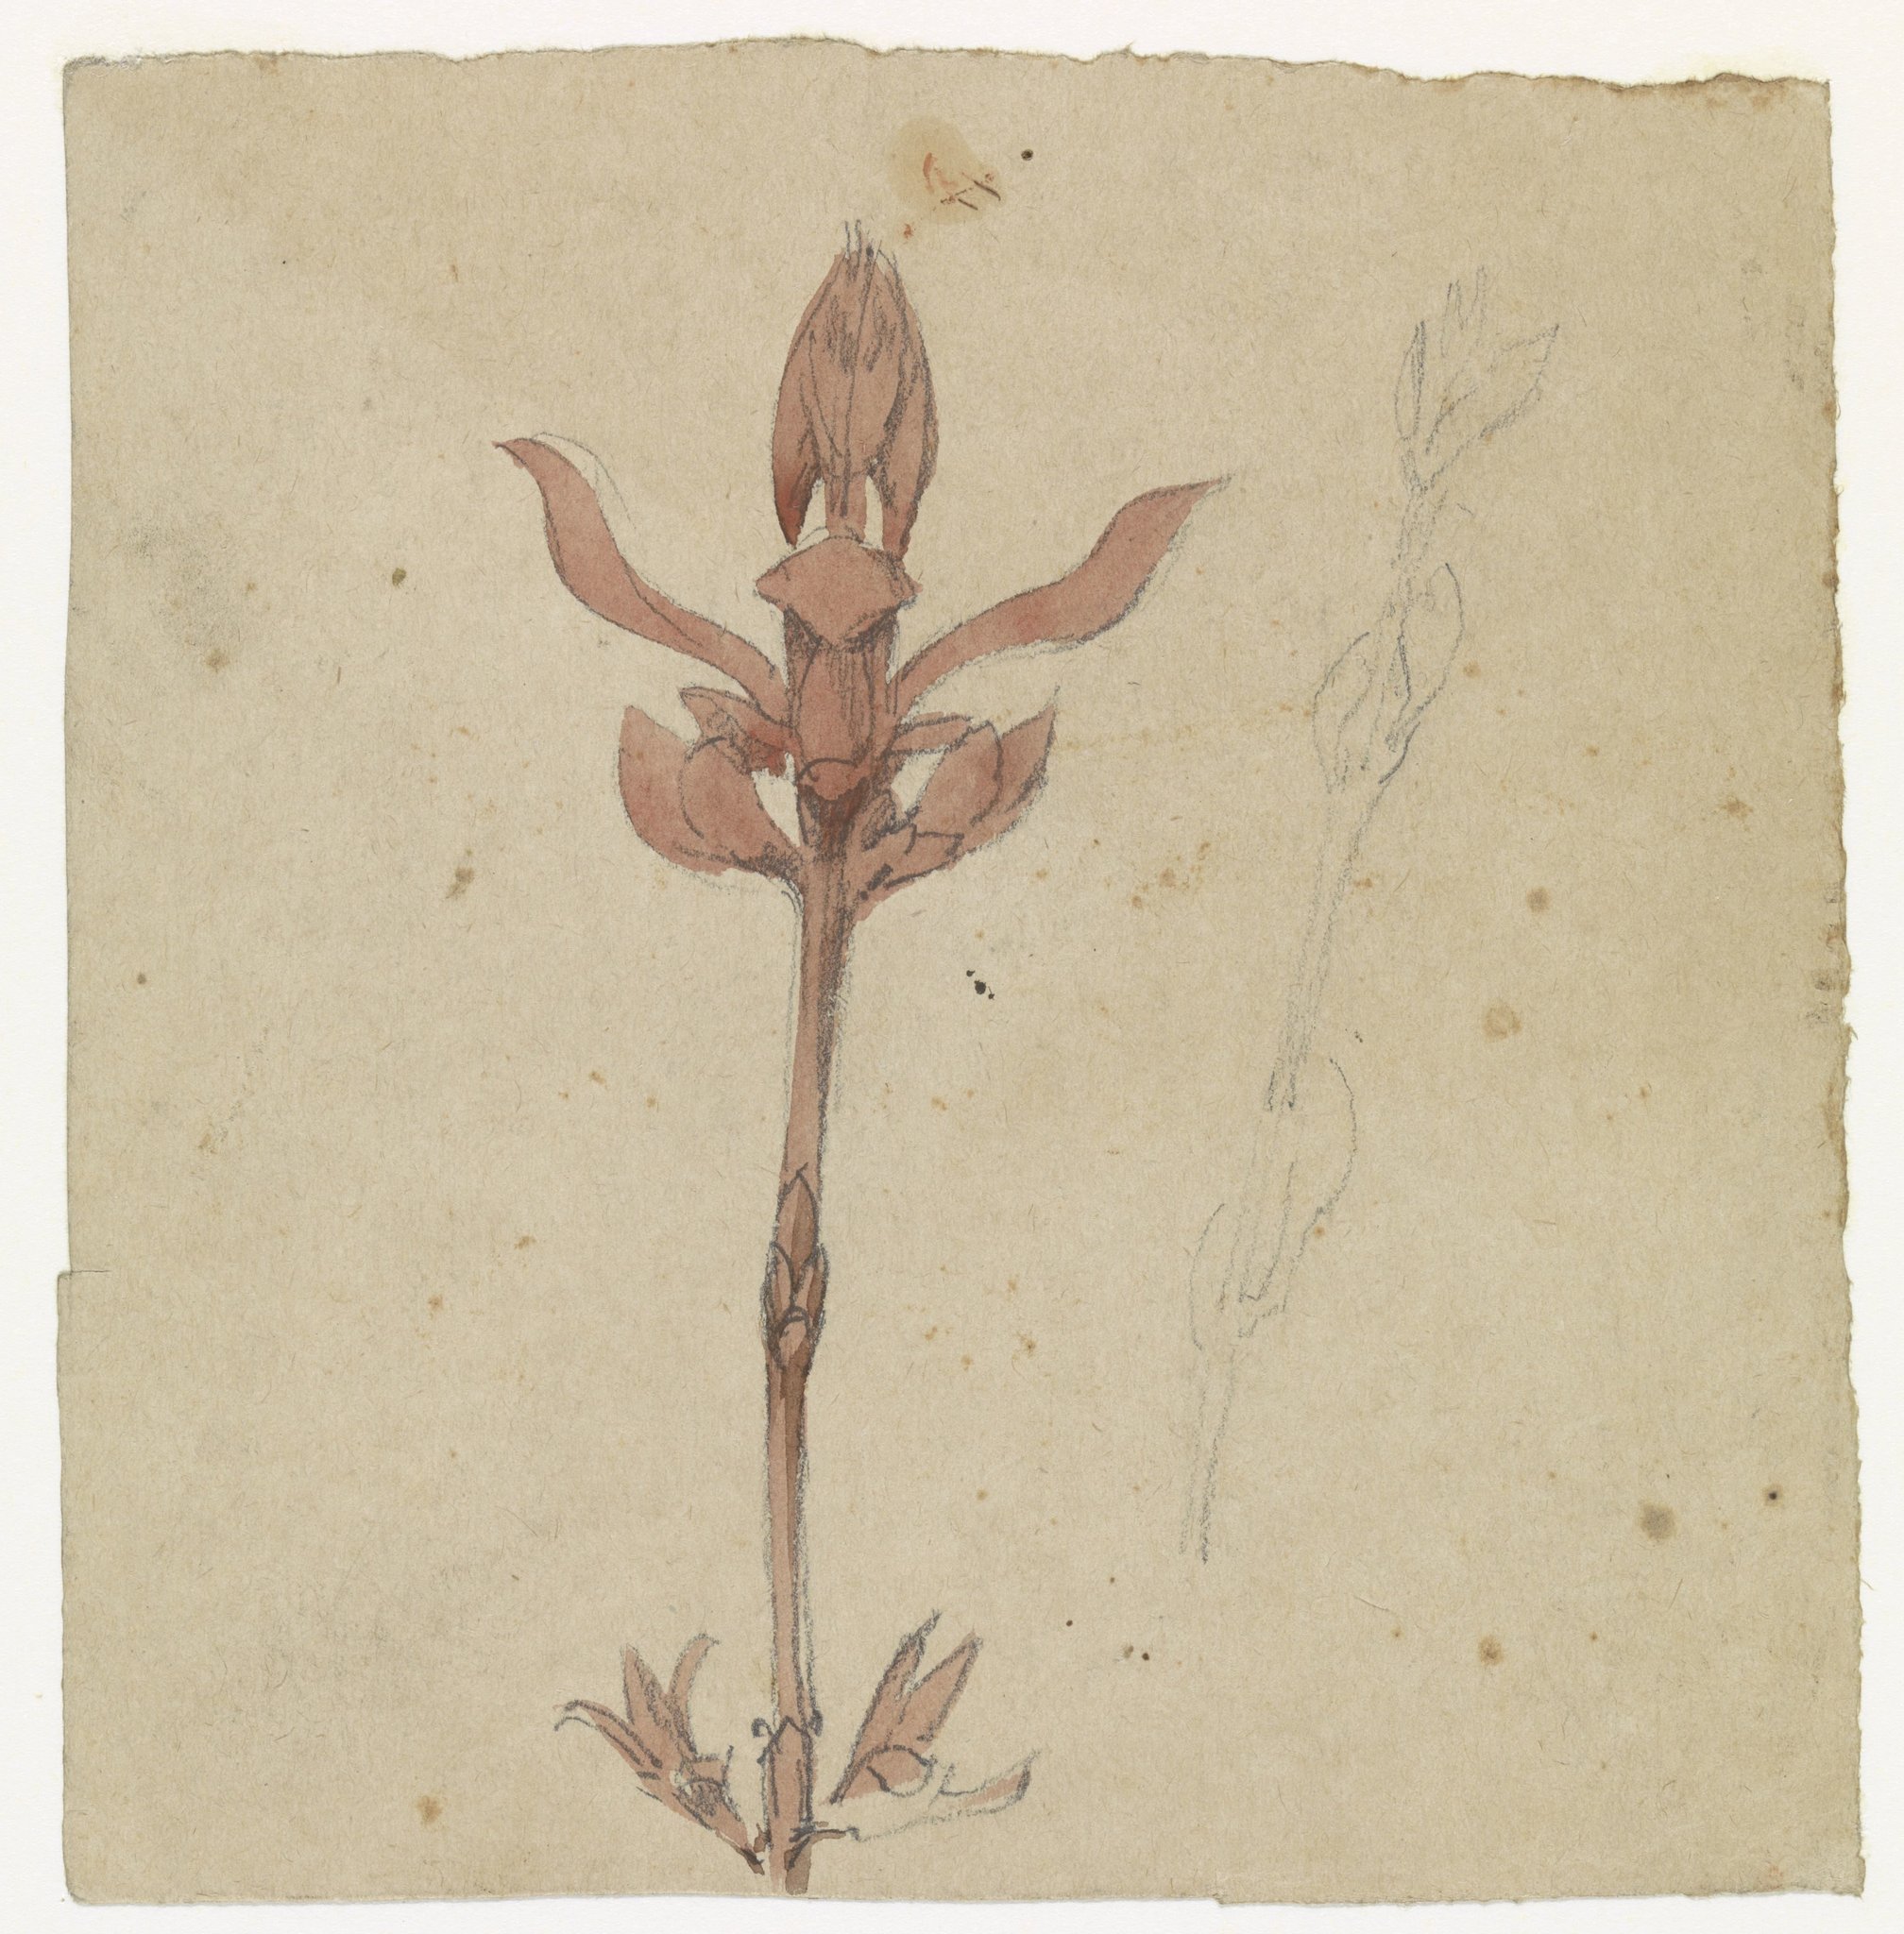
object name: drawing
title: Kastanjetak, in knop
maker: antoon derkinderen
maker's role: draughtsman, painter, print maker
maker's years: 1859-1925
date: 1869-1925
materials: paper, pencil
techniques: brush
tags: trees: chestnut-tree (sprig, twig)